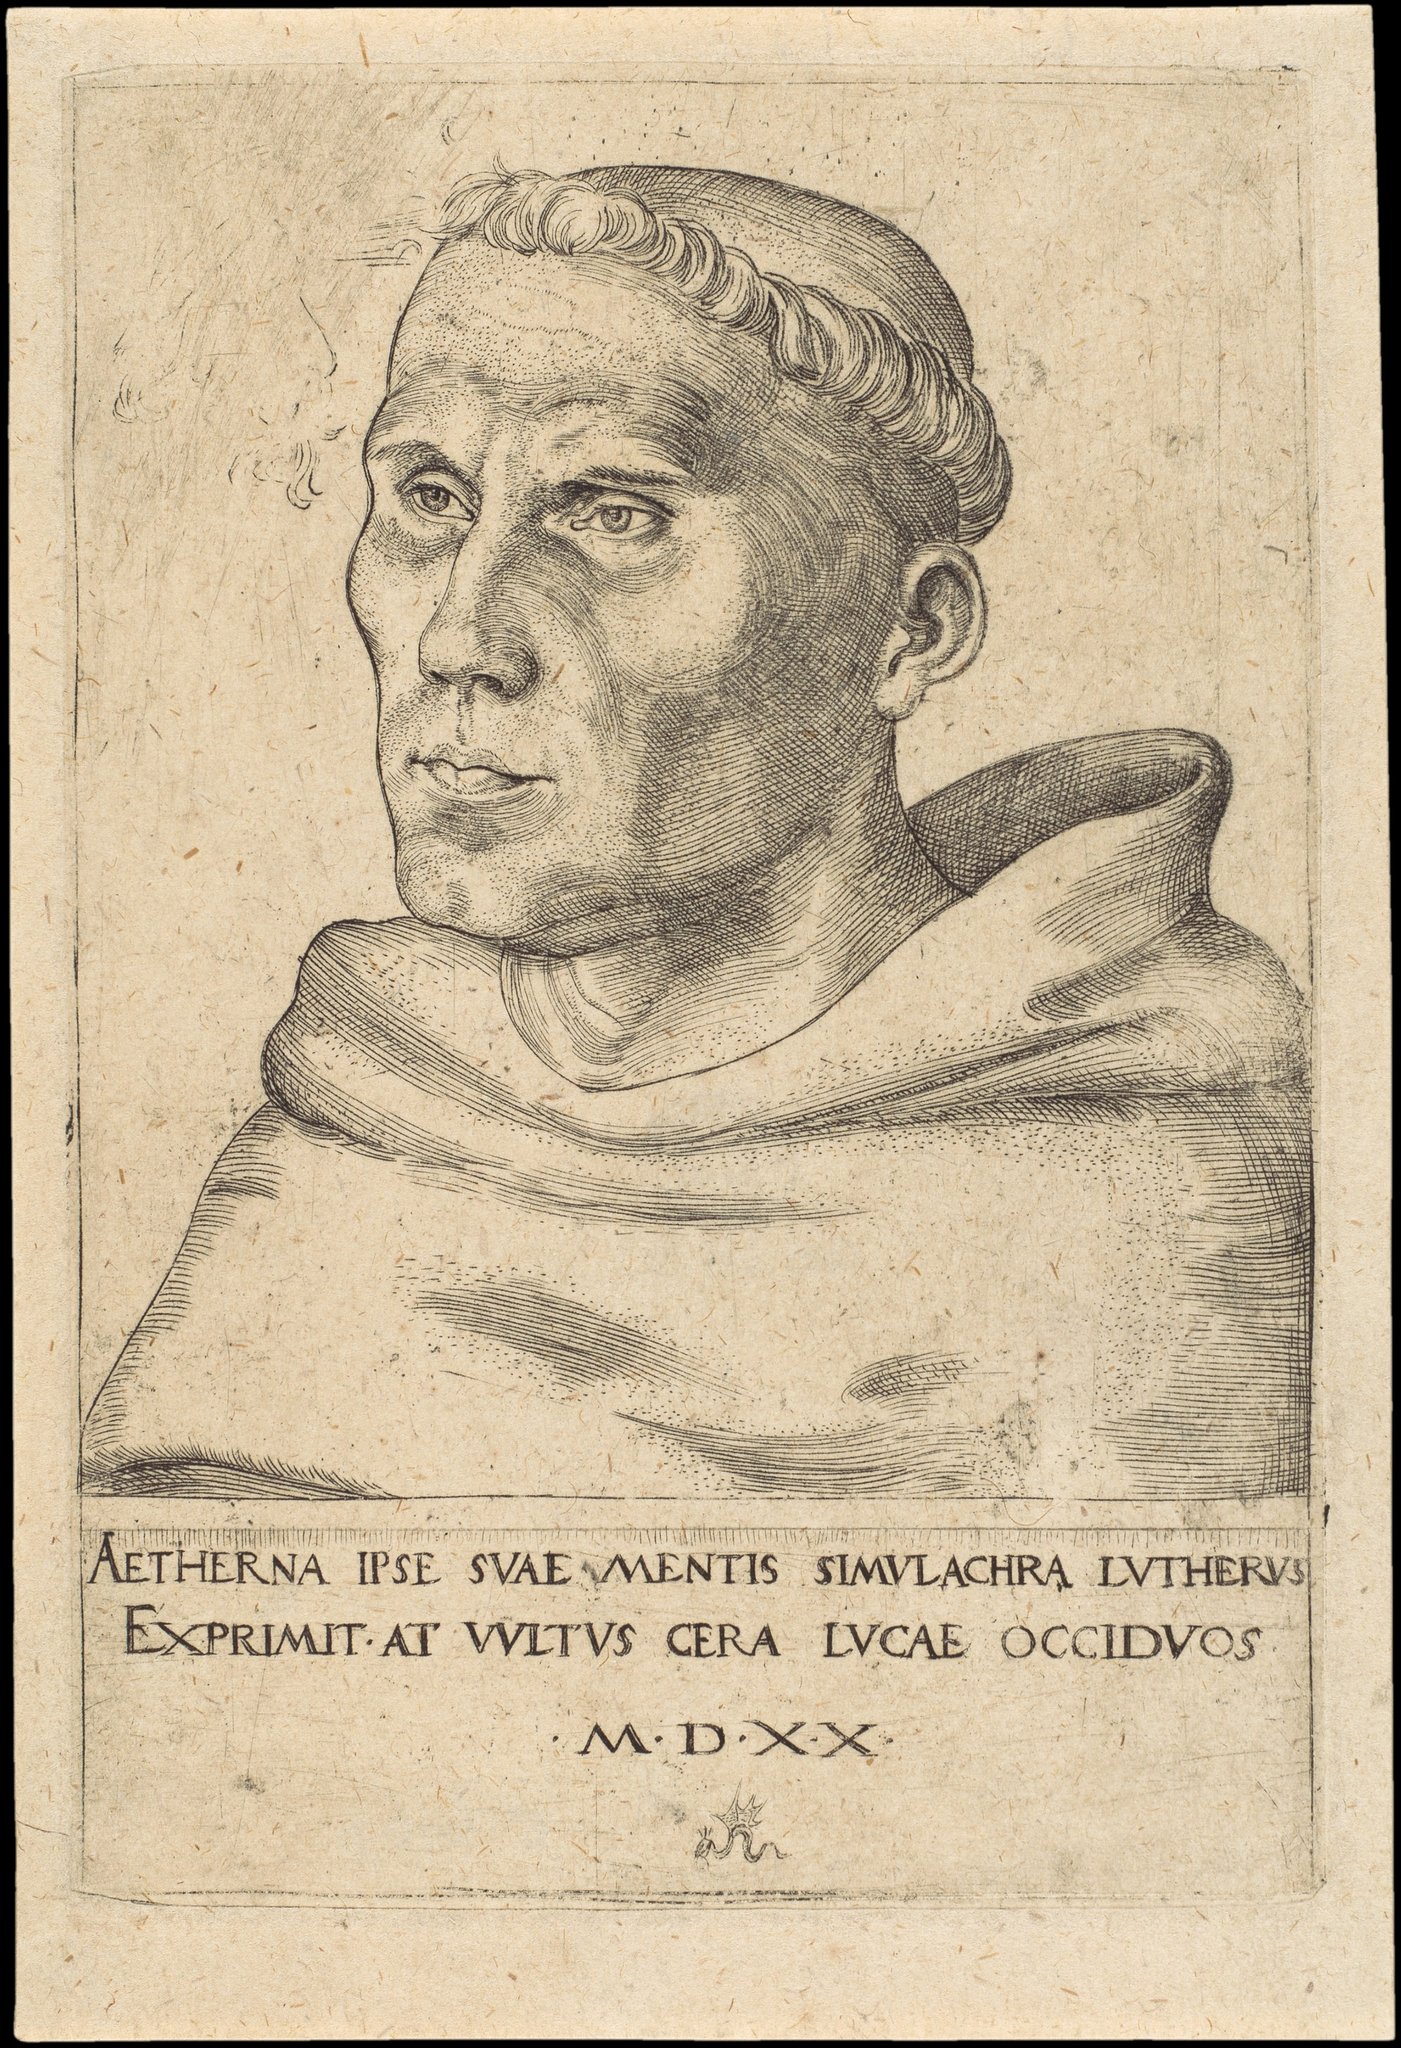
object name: print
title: Martin Luther as an Augustinian Monk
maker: lucas cranach the elder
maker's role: artist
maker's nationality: german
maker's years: 1472-1553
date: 1520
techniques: engraving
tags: martin luther,men,portraits,monks